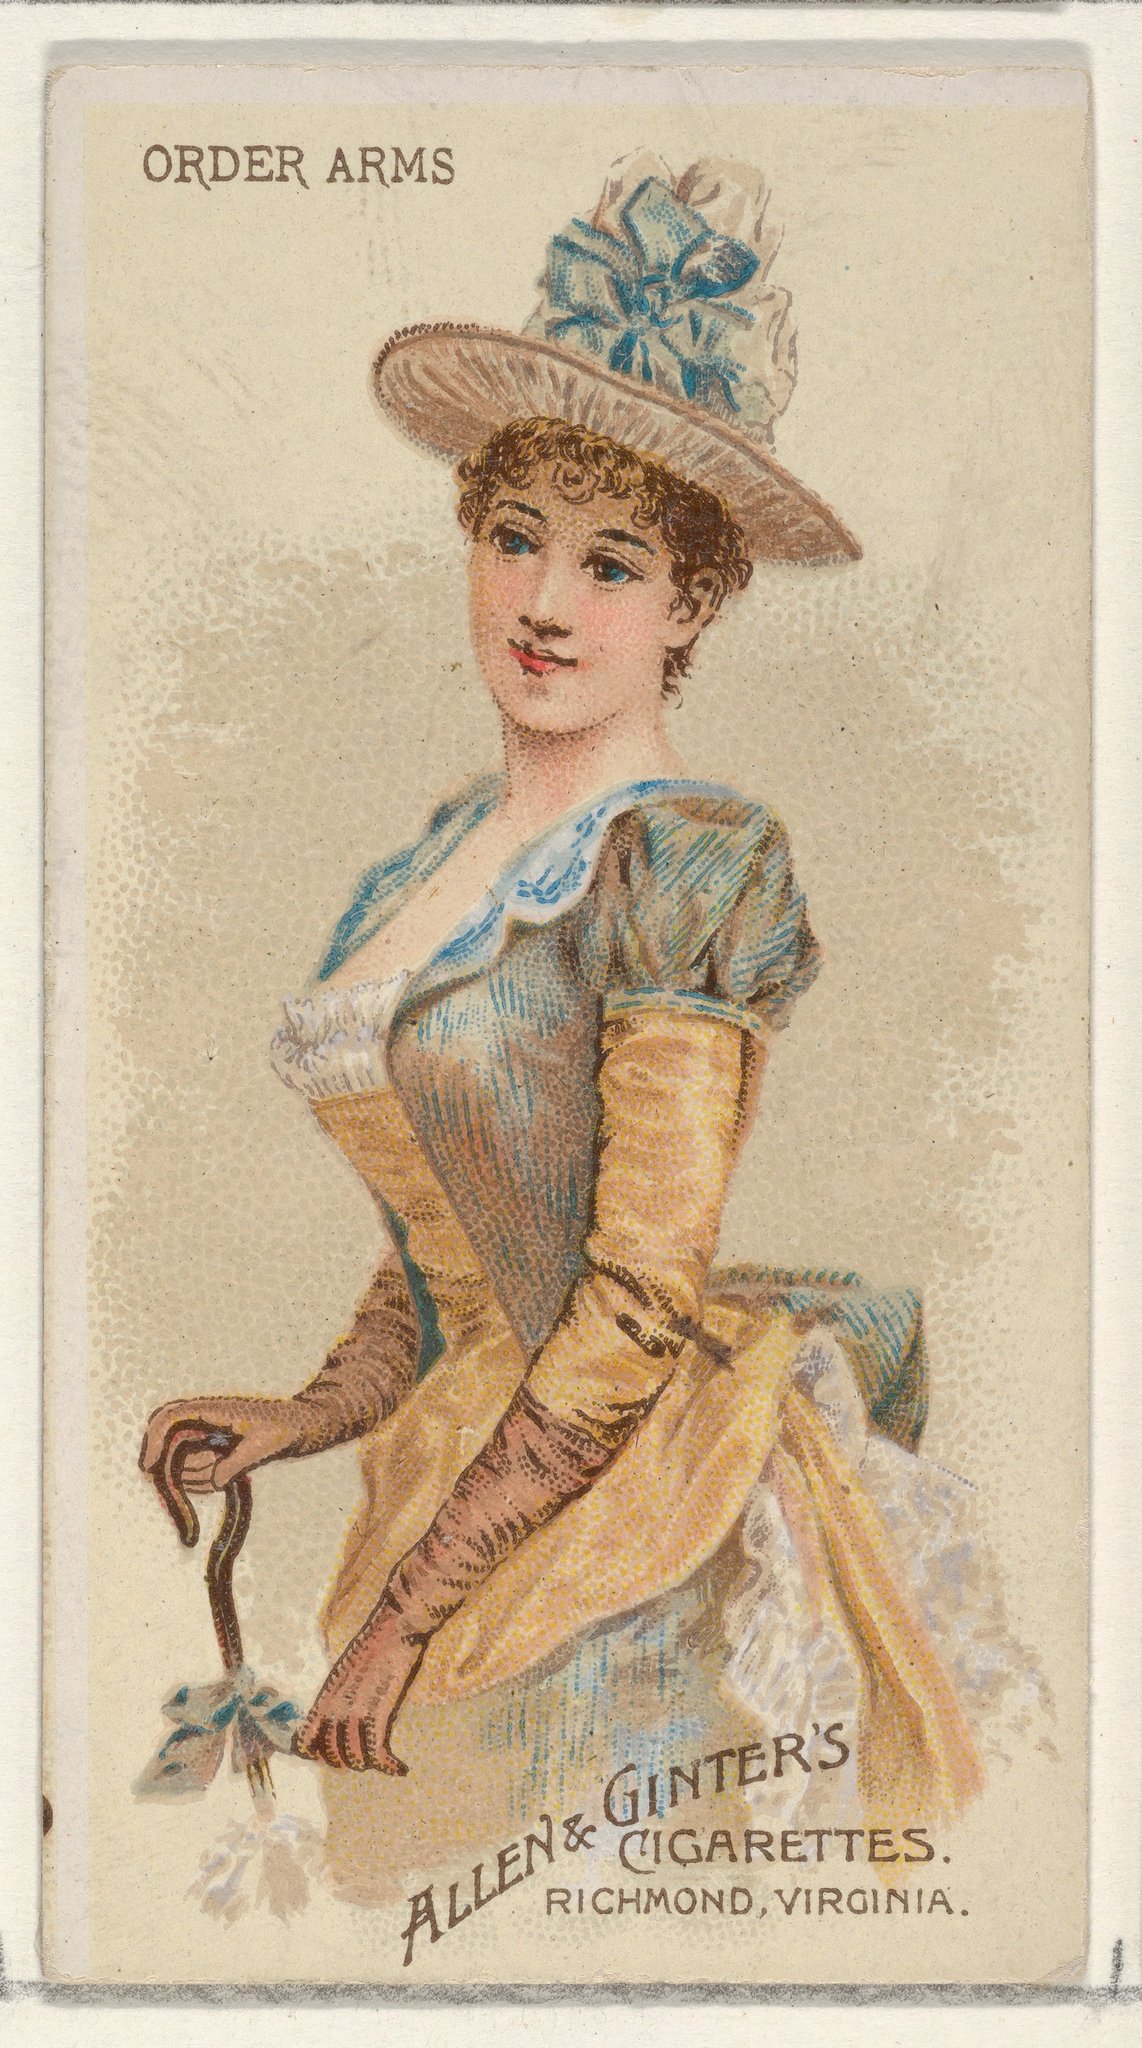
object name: print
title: Order Arms, from the Parasol Drills series (N18) for Allen & Ginter Cigarettes Brands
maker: allen & ginter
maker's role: publisher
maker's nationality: american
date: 1888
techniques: color lithograph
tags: women